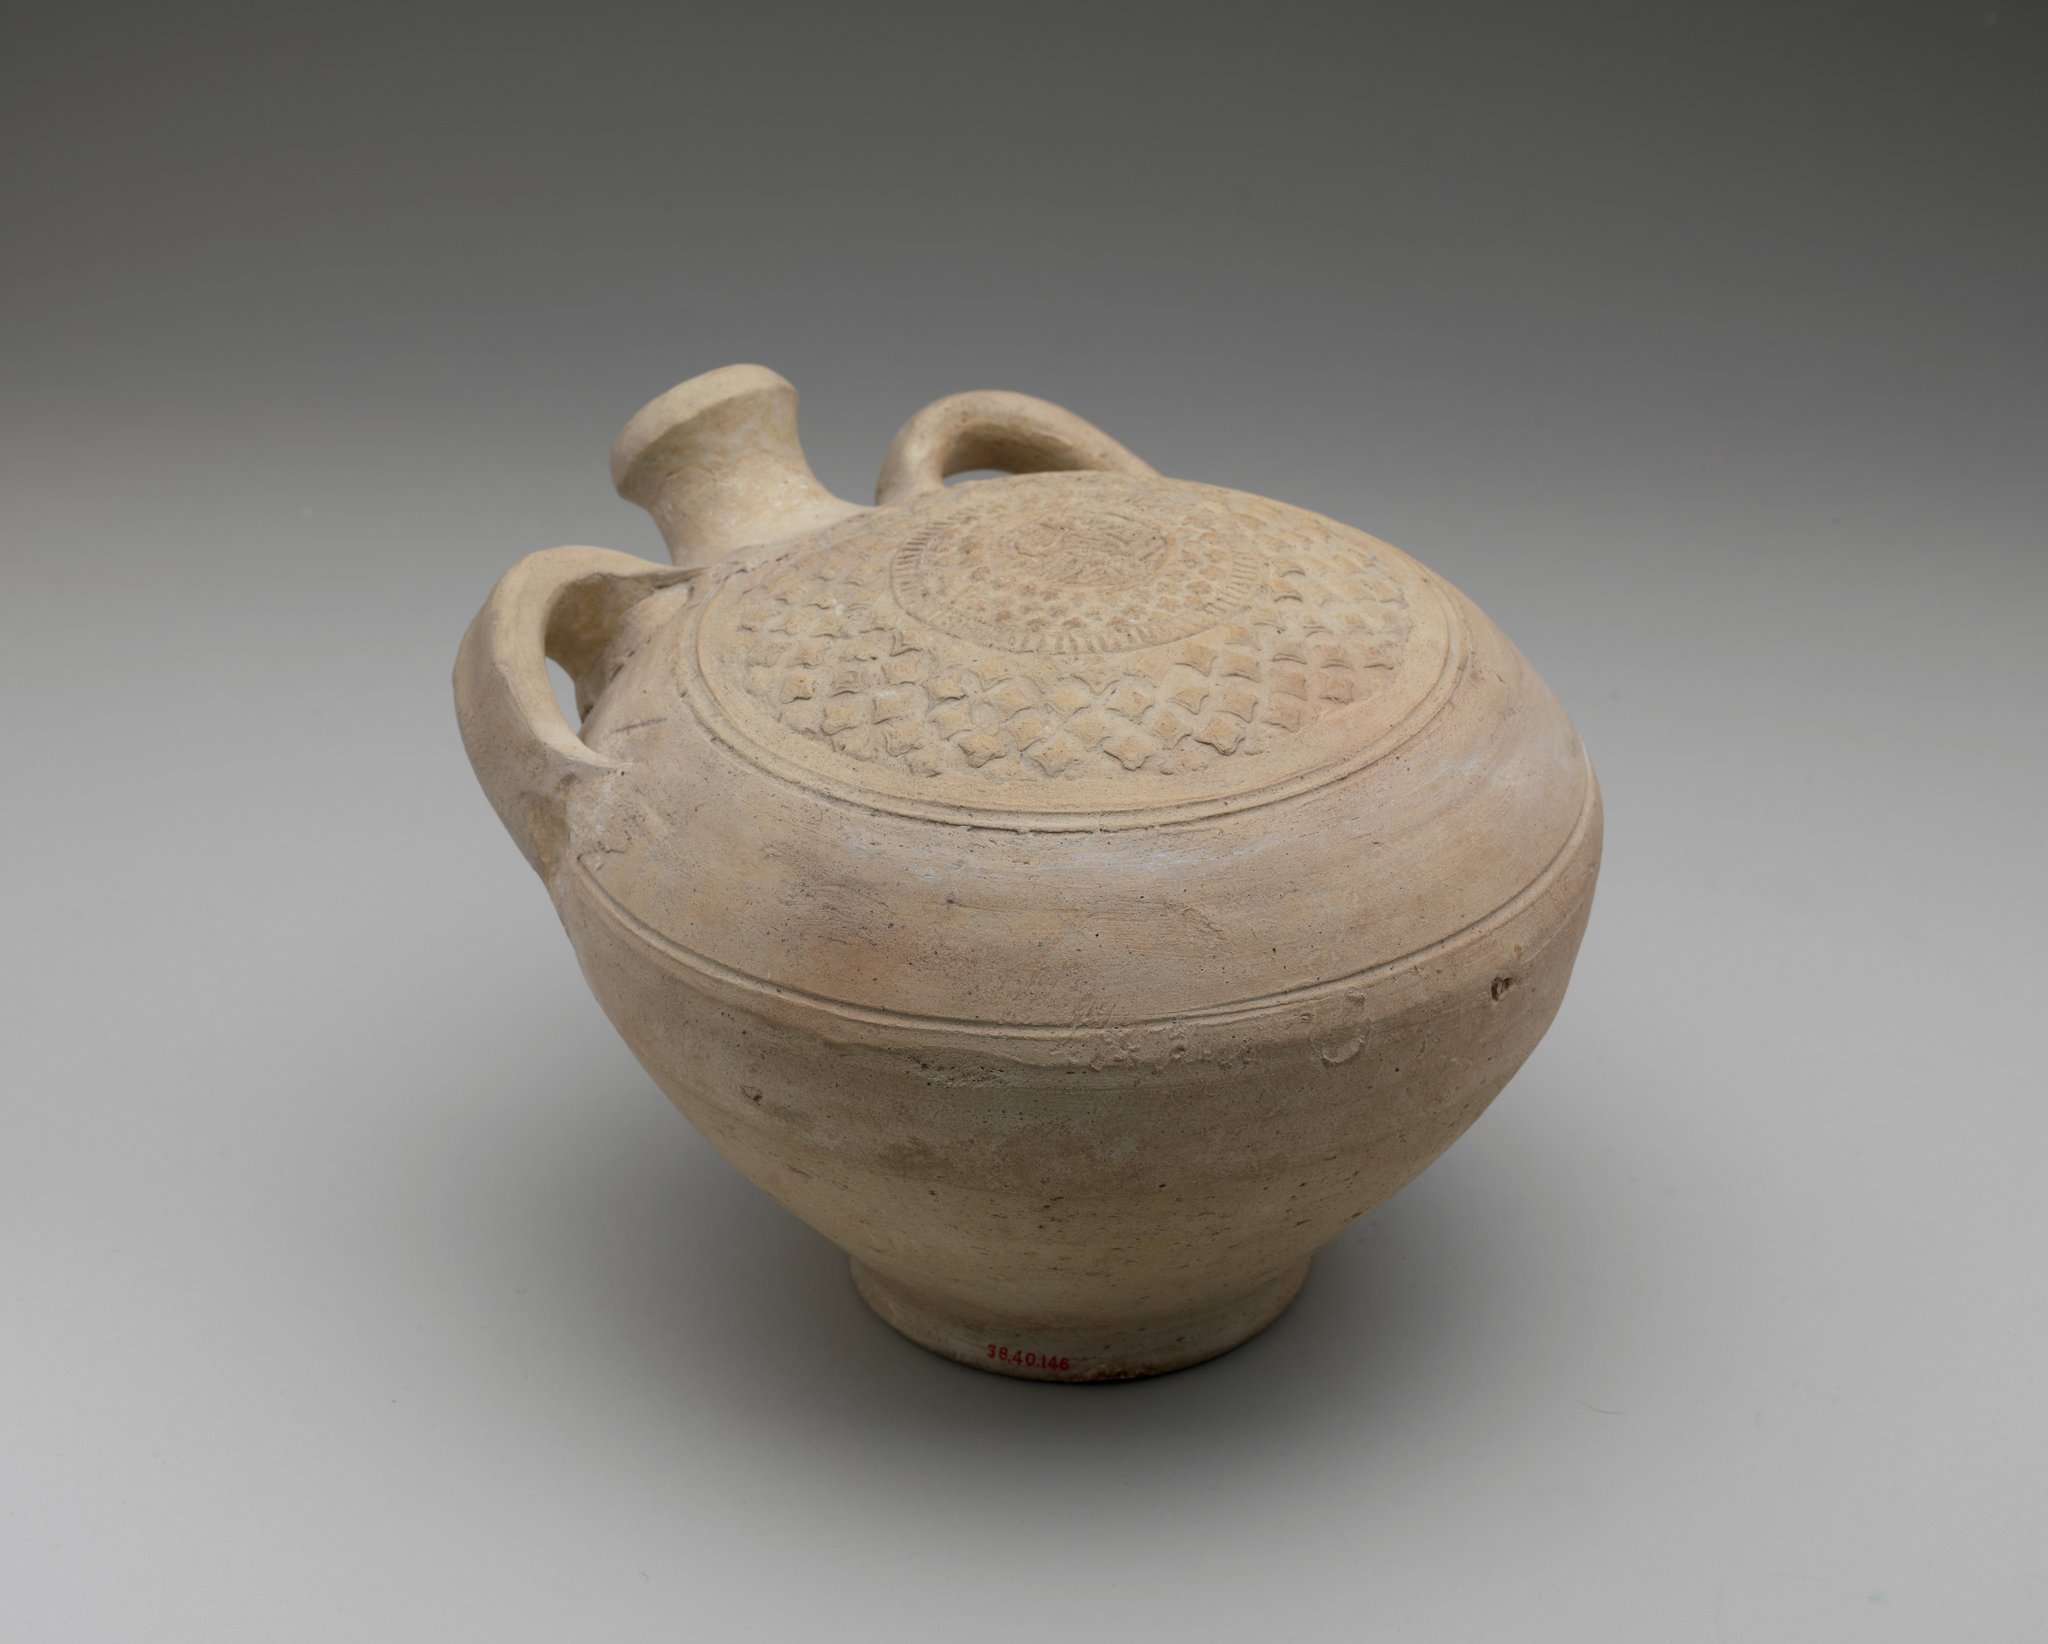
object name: flask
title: Flask with Molded Decoration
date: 1101-1300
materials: earthenware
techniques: molding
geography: iran